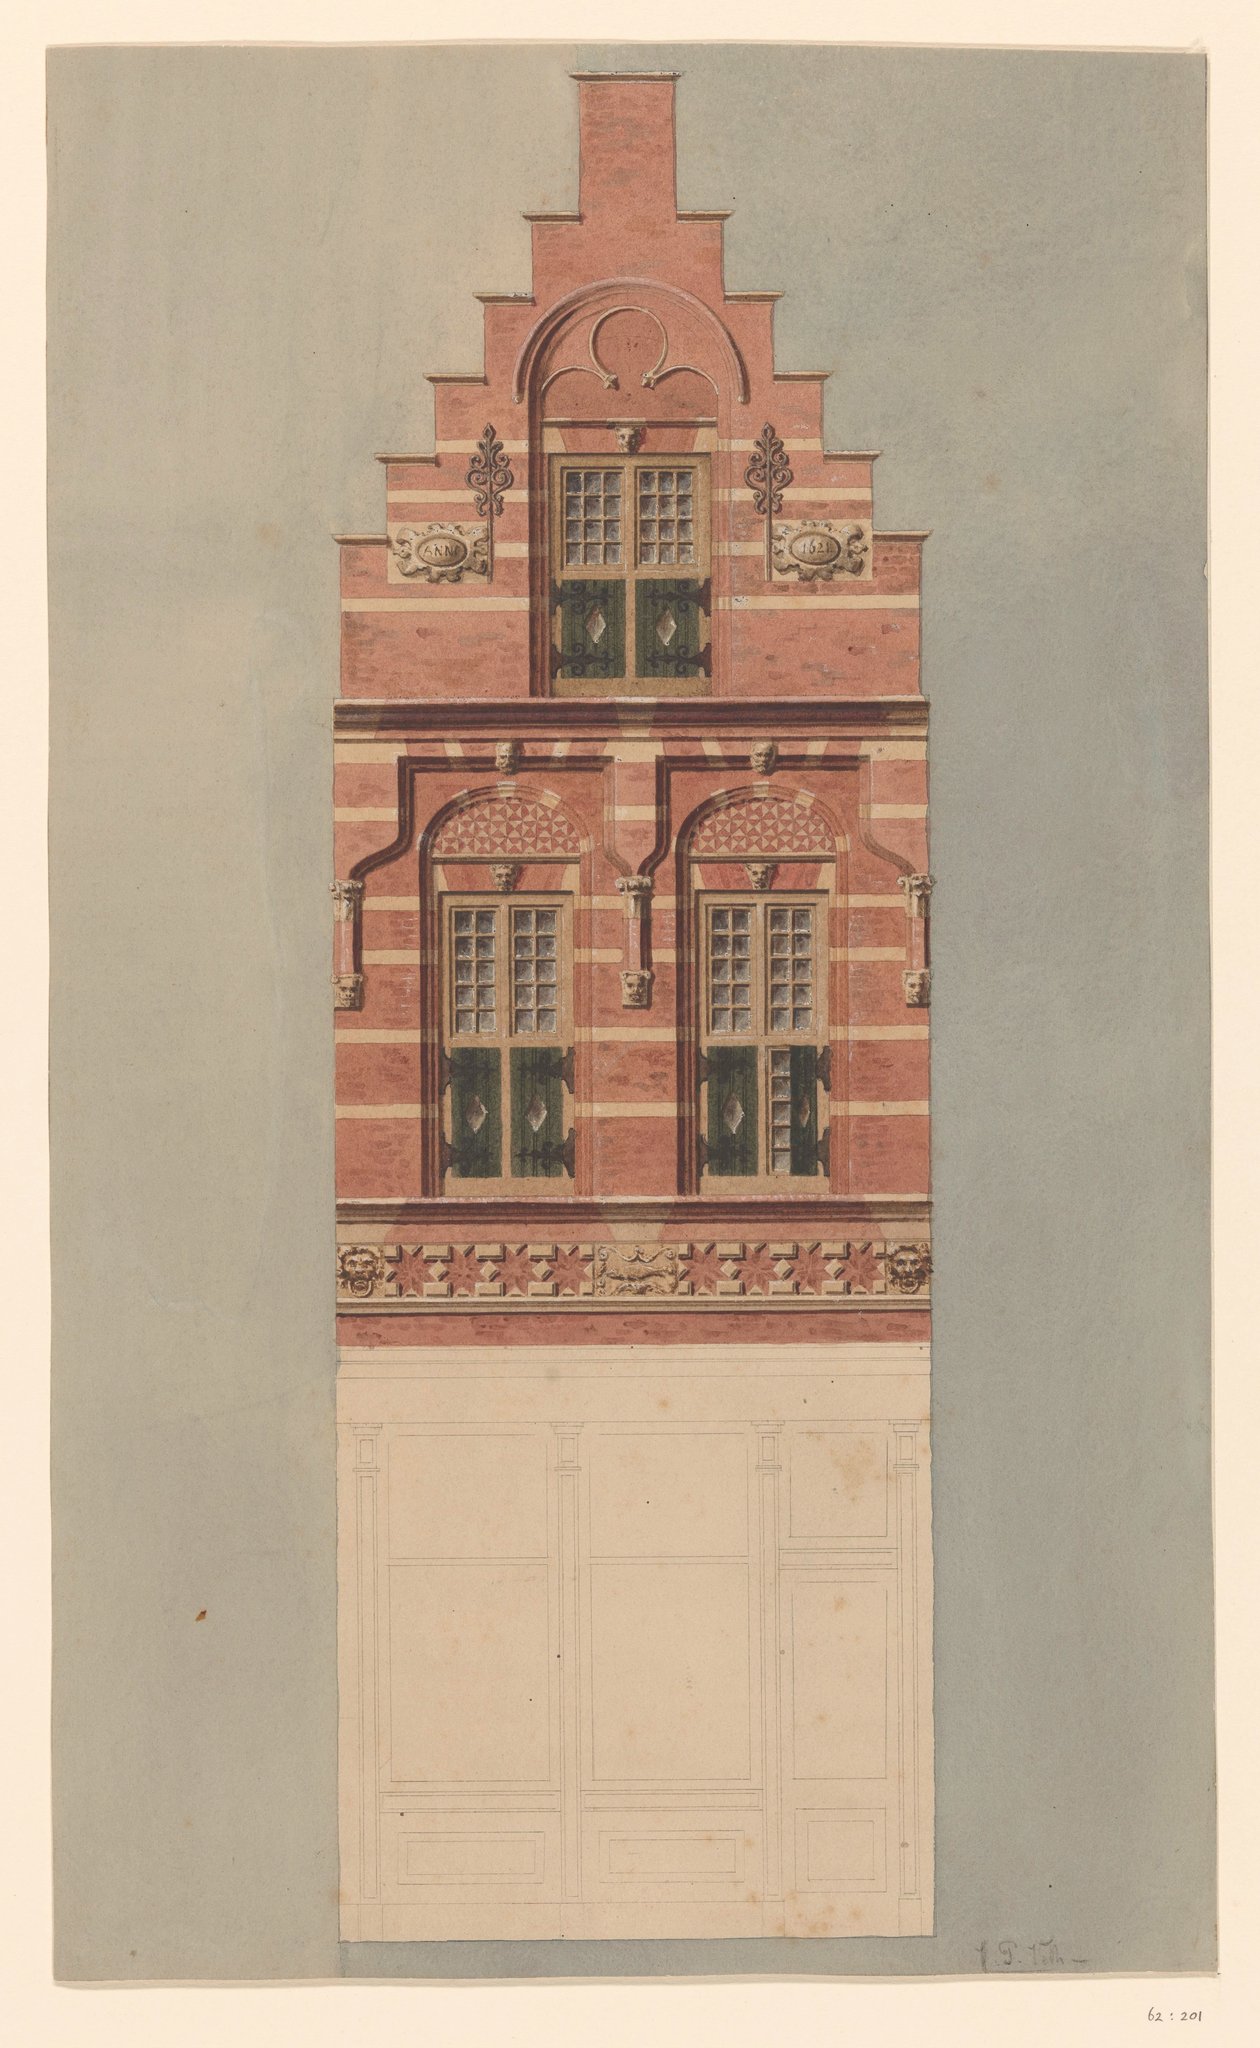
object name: drawing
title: De gevel van Huis Crimpert Salm te Dordrecht uit 1621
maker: jan veth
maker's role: designer, draughtsman, painter, print maker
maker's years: 1864-1925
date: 1874-1925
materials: paper, pencil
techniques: brush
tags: façade (of house or building)